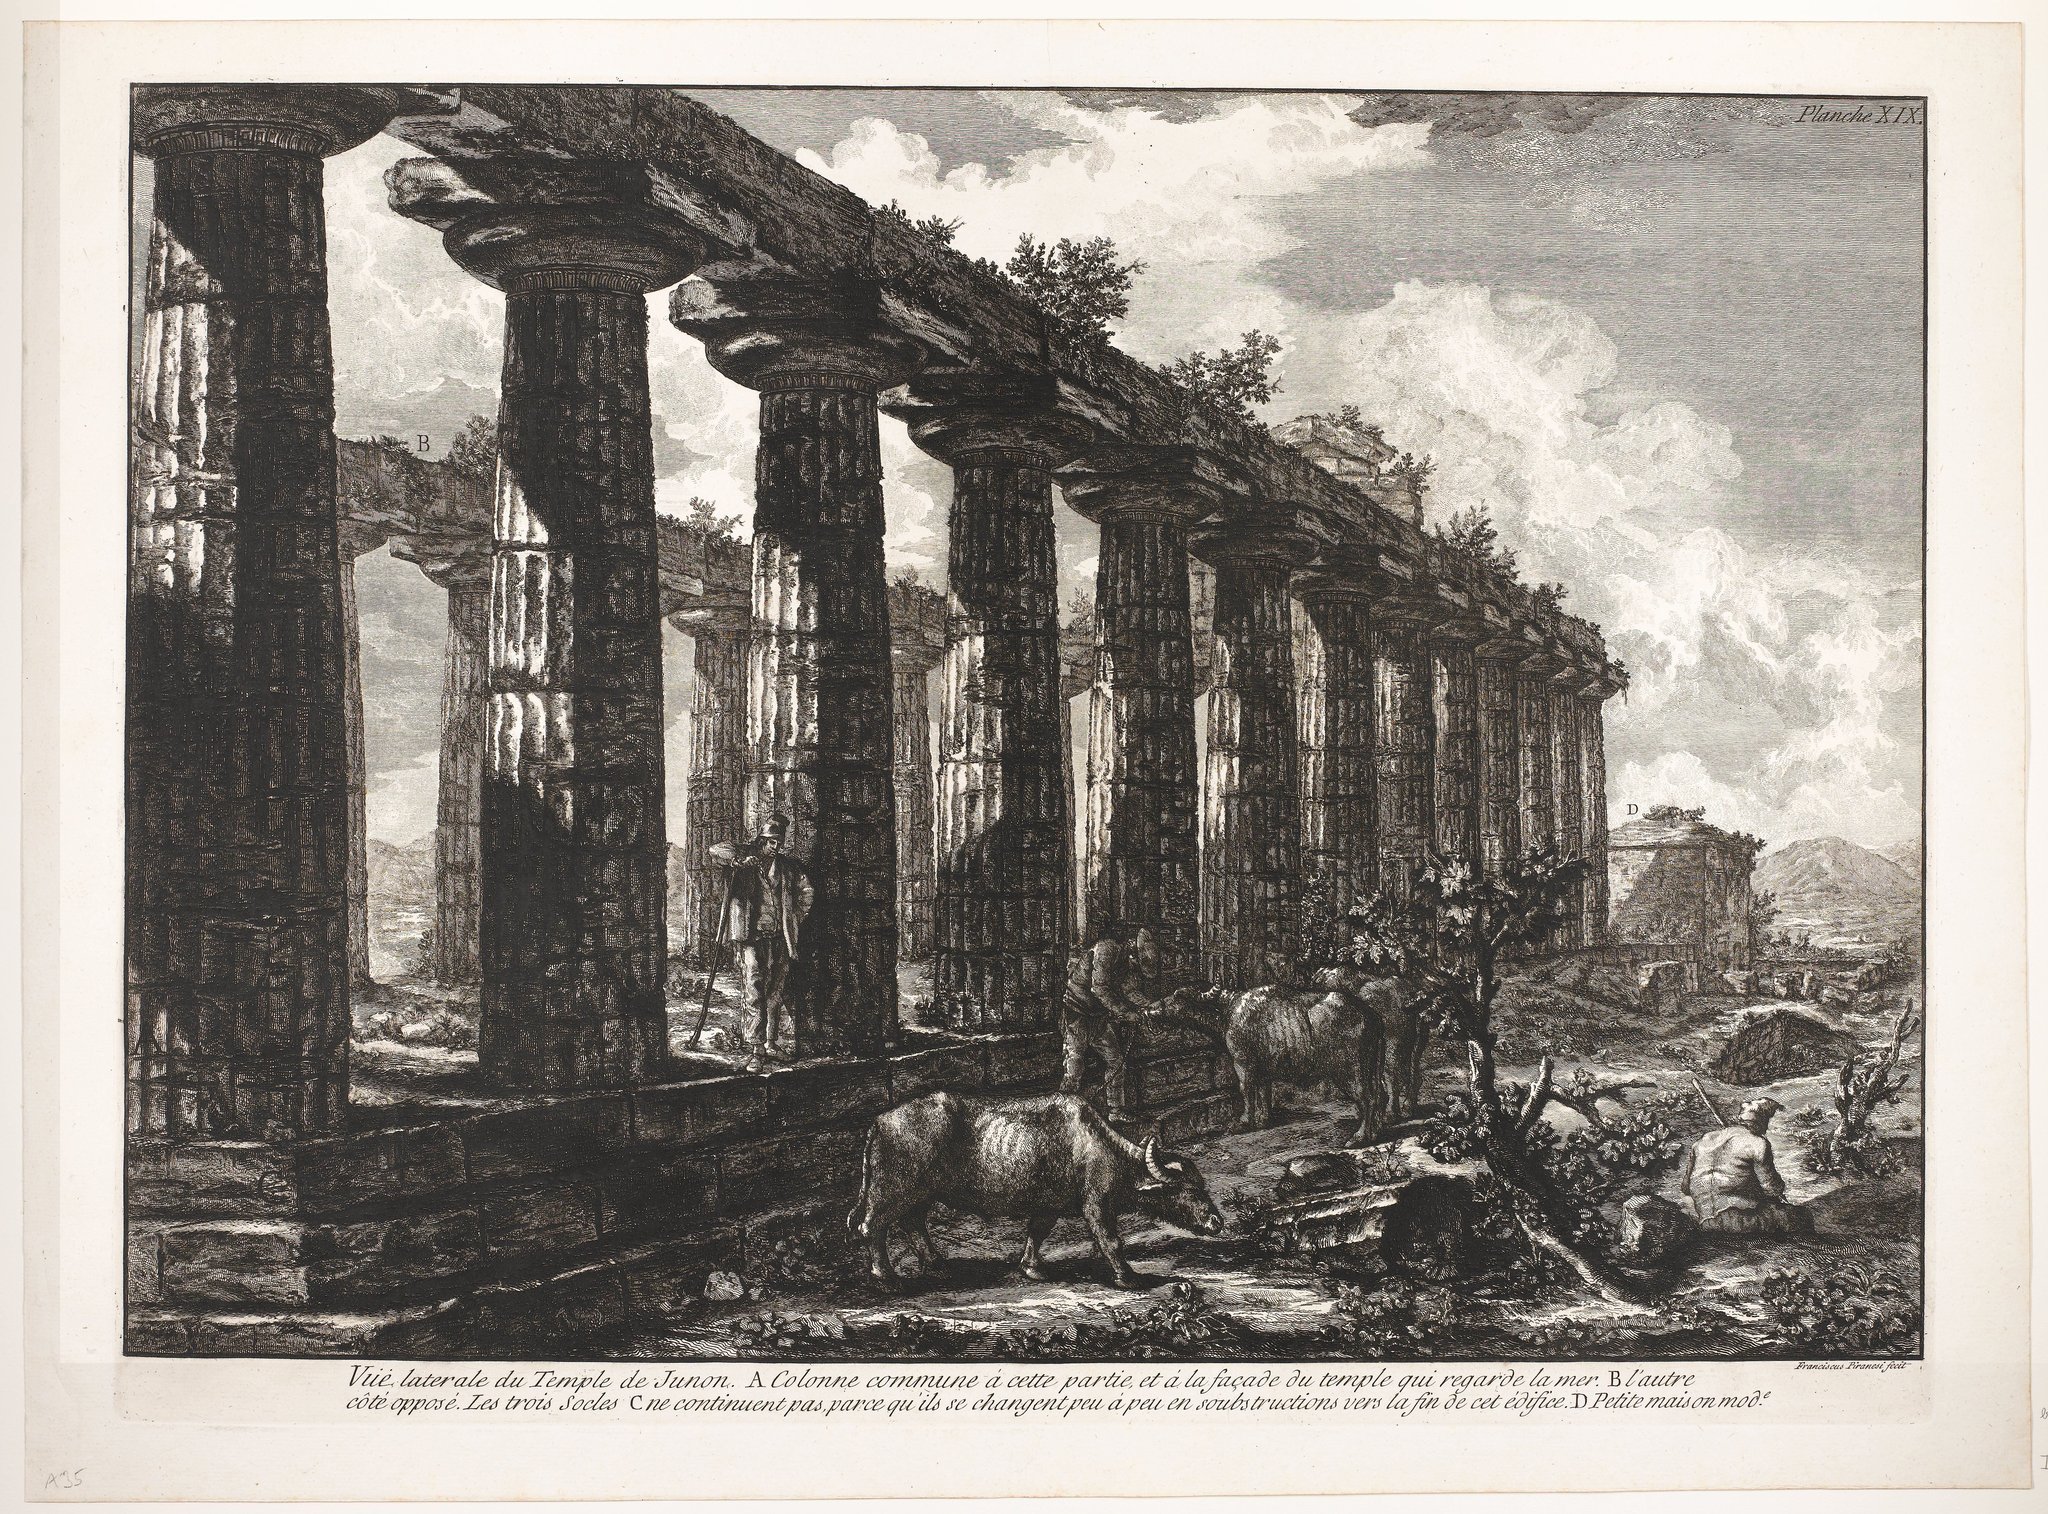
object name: print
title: Tempio di Atena in Paestum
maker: francesco piranesi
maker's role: print maker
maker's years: 1758-1810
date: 1768-1810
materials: paper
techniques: etching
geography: italy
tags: cow, ruin of a building ~ architecture, landscape with ruins, temple, shrine ~ non-christian religions, exterior ~ representation of a building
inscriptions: collector's mark: Lugt 2228, collector's mark: Lugt 2760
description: Gezicht op de ruïnes van de Tempio di Atena (of Tempio di Cerere) te Paestum. Tekst in het Italiaans in ondermarge. Rechtsboven: Planche XIX.